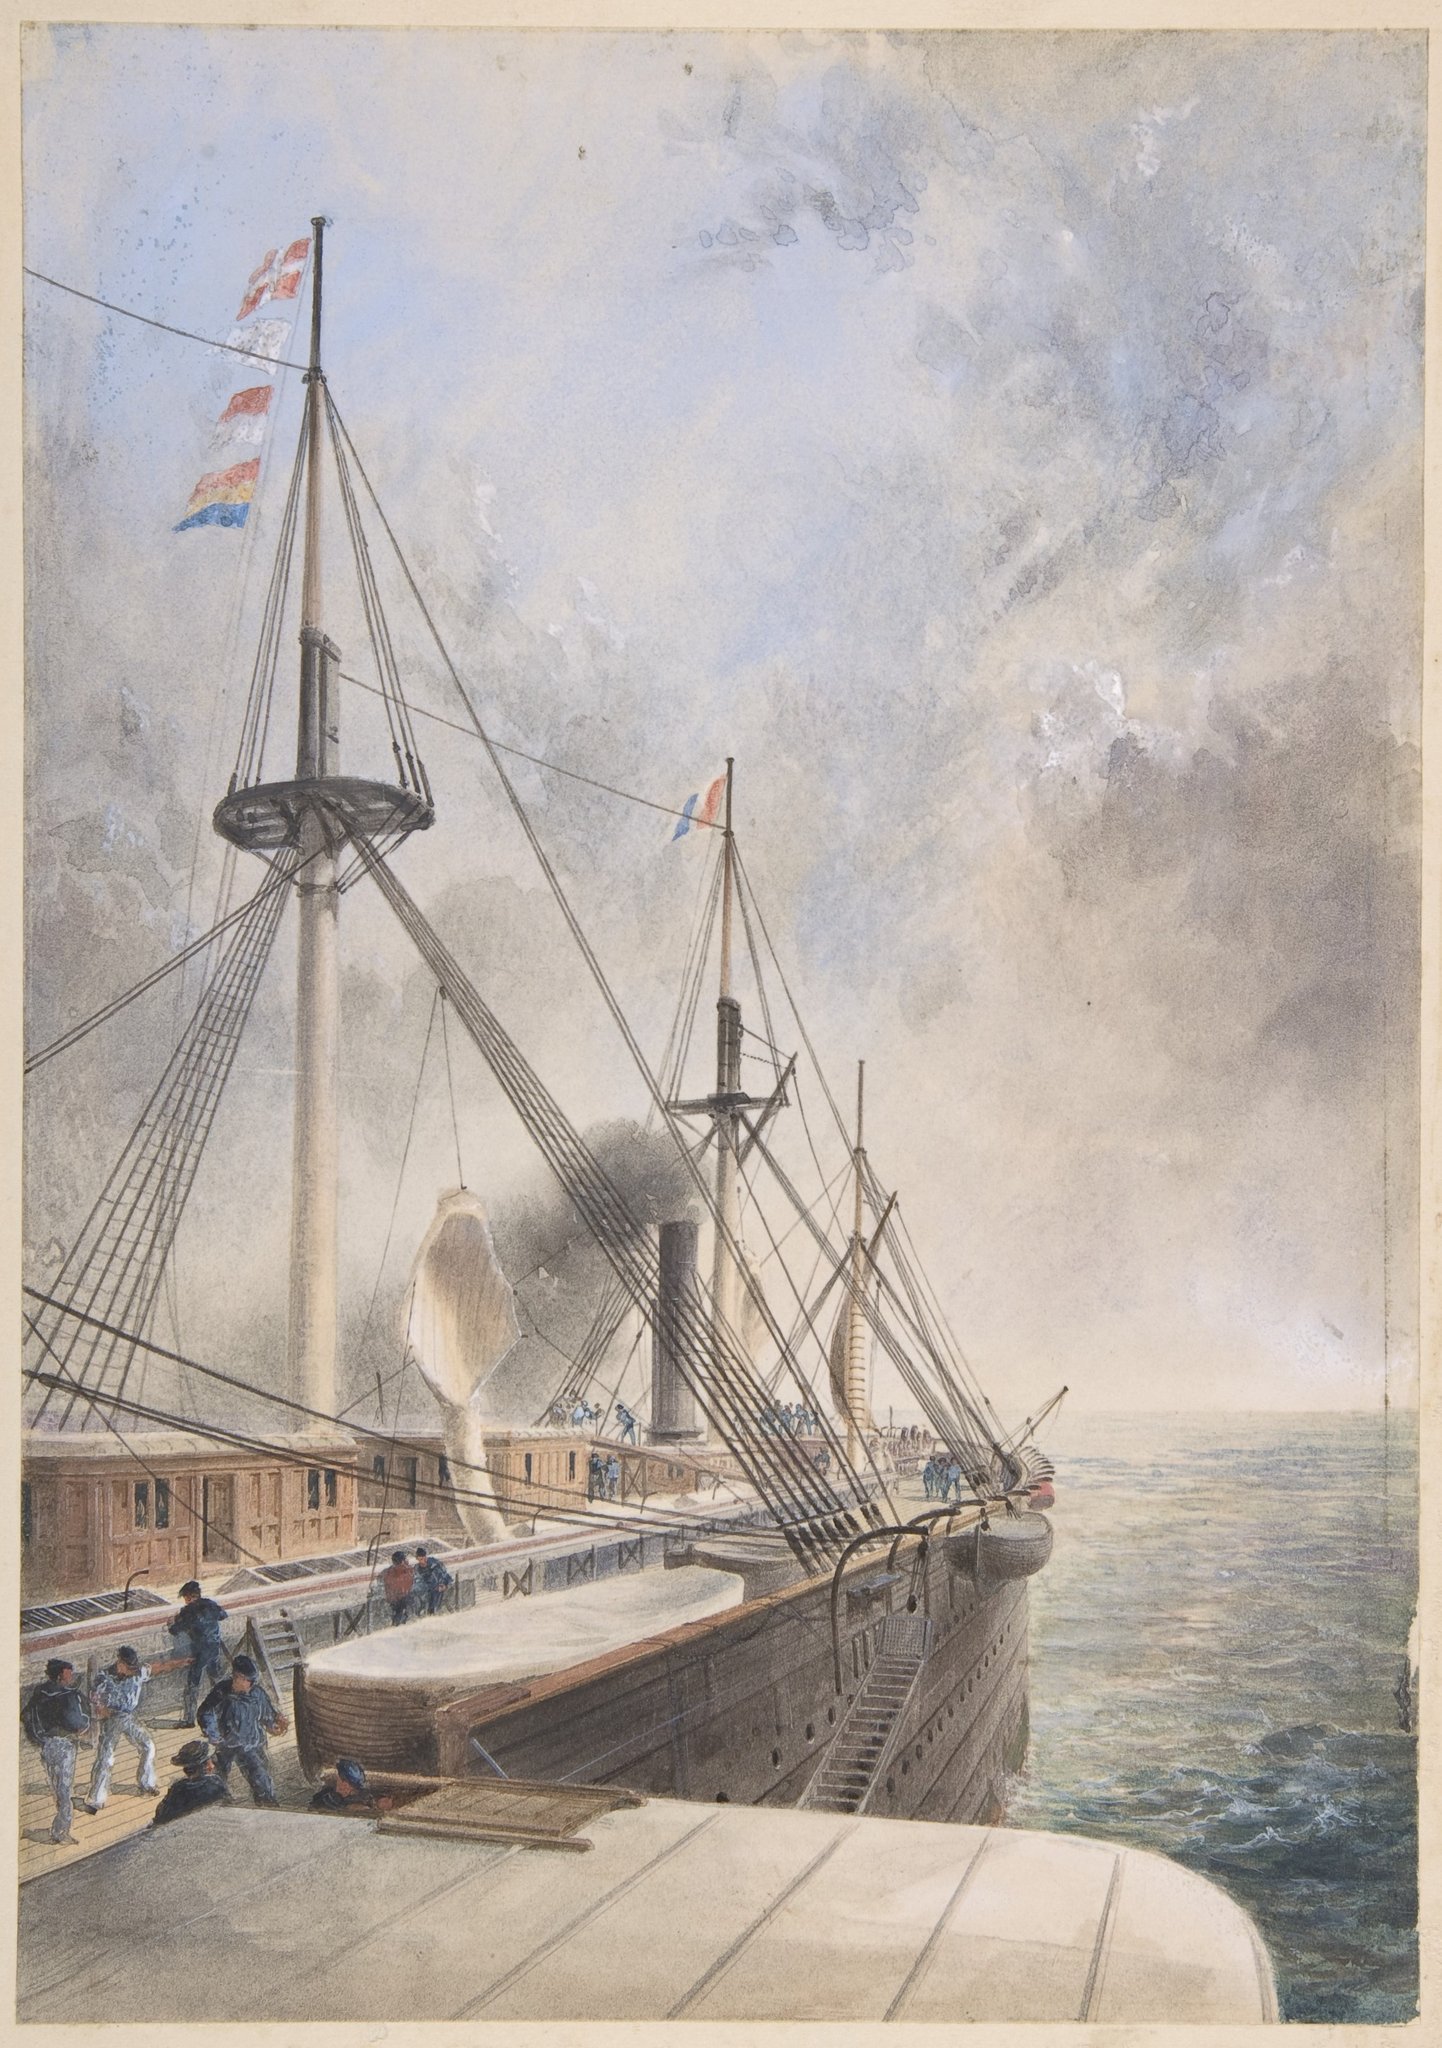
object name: drawing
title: View Looking Aft from the Port Paddle-box on the Deck of the Great Eastern: Showing the Trough for the Cable, etc.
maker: robert charles dudley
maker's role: artist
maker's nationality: british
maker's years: 1826-1909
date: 1865-1866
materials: gouache, watercolor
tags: ships,transatlantic cable